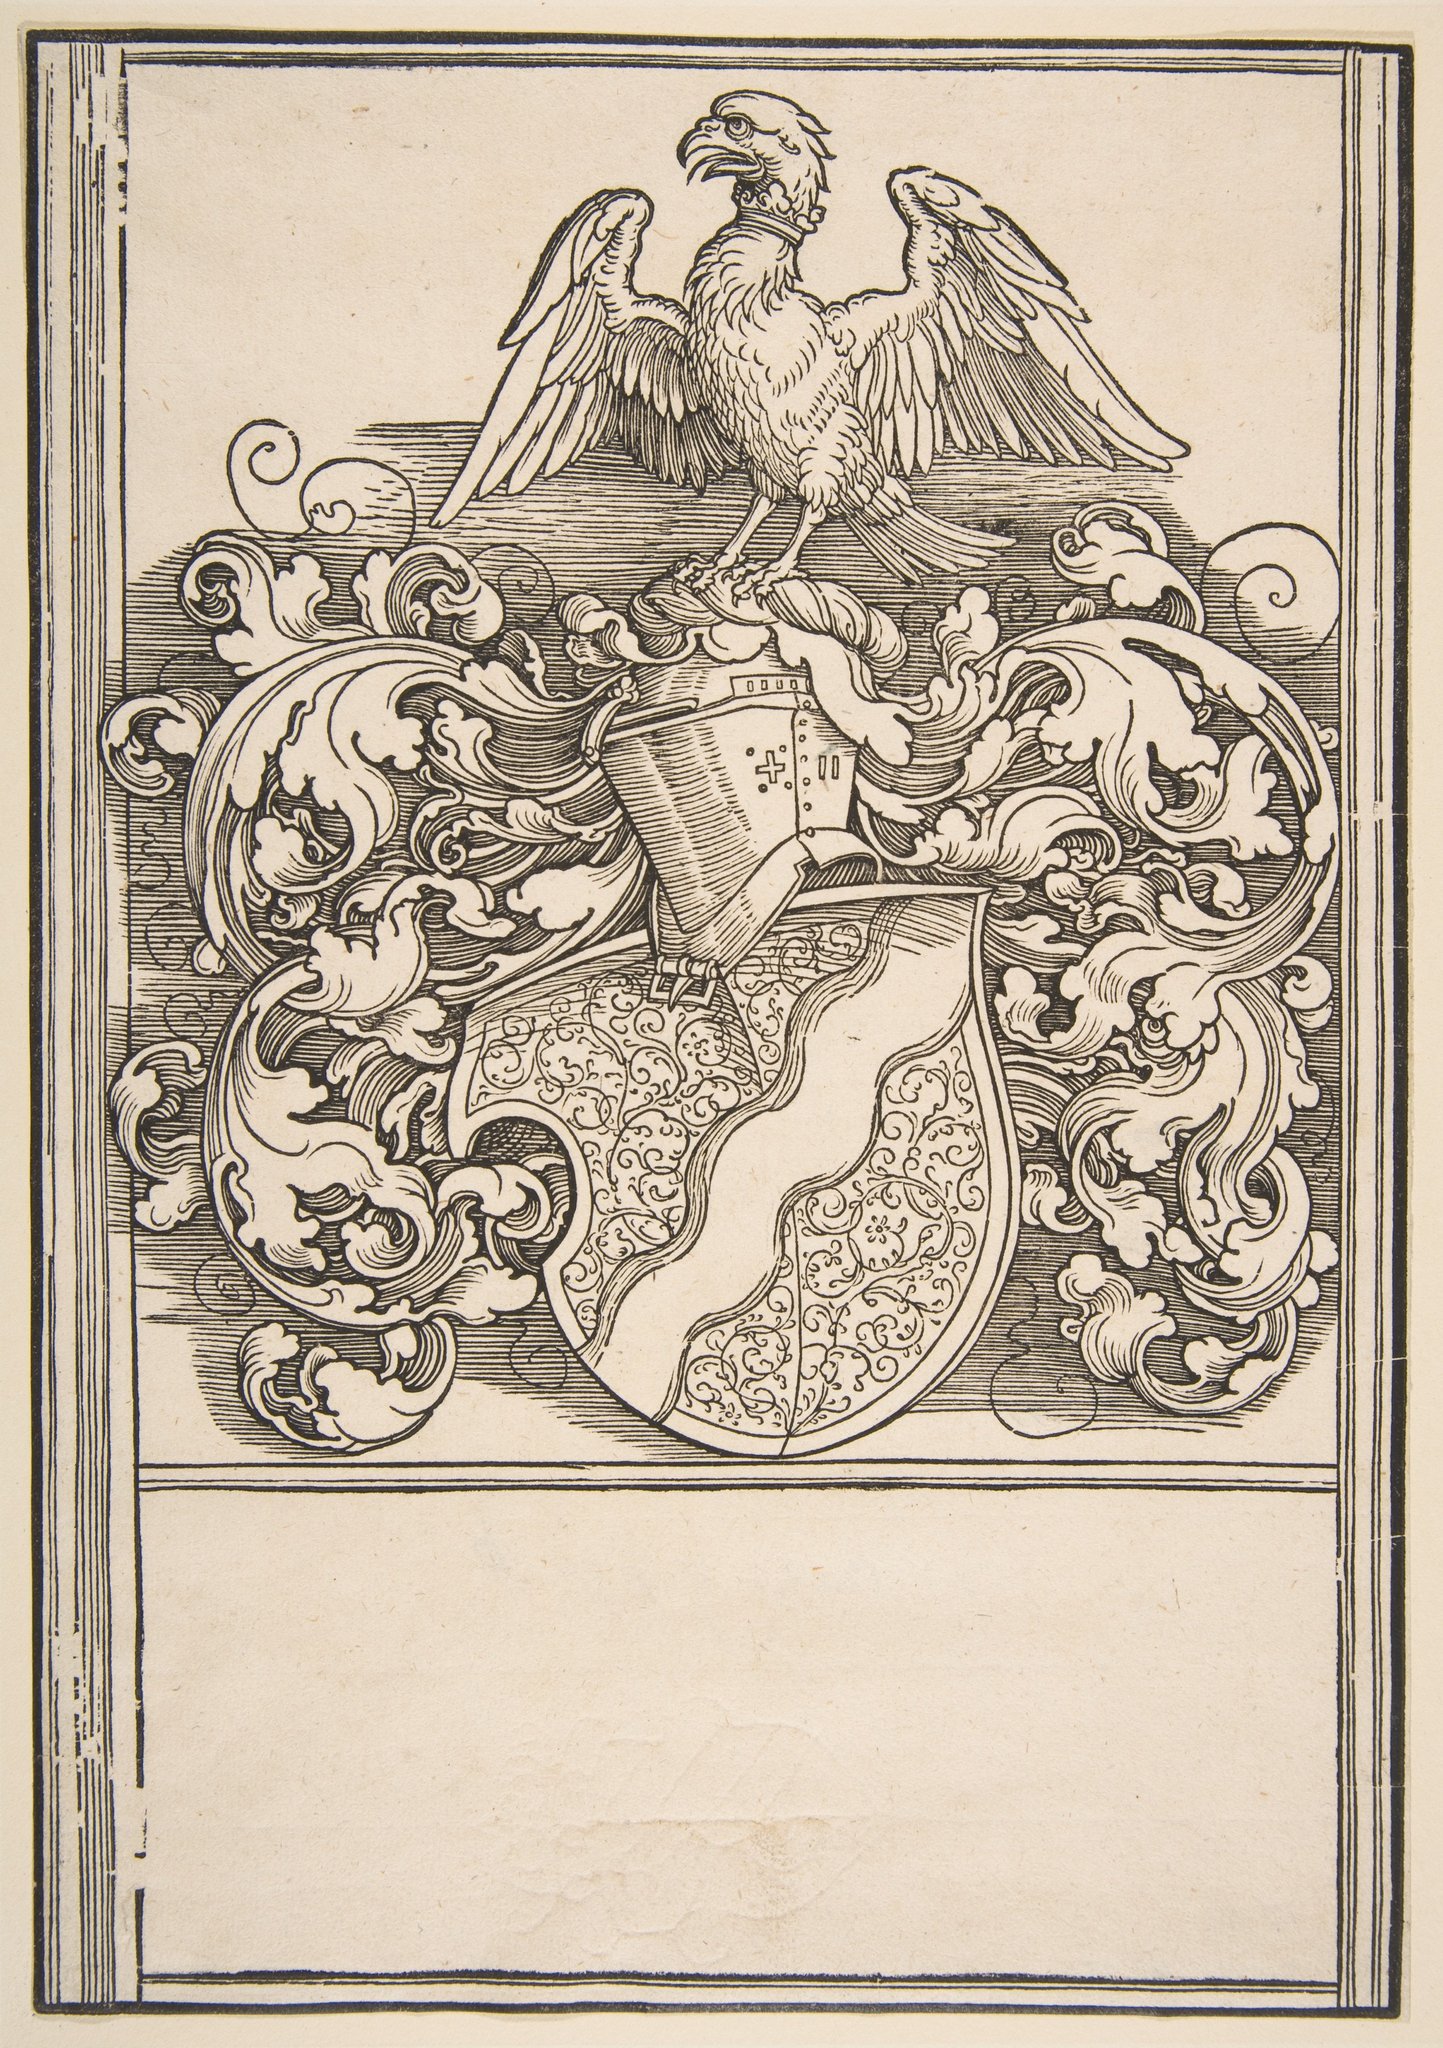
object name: print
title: Arms of Michel Beheim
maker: albrecht dürer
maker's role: artist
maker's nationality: german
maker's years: 1471-1528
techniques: woodcut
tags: birds,coat of arms